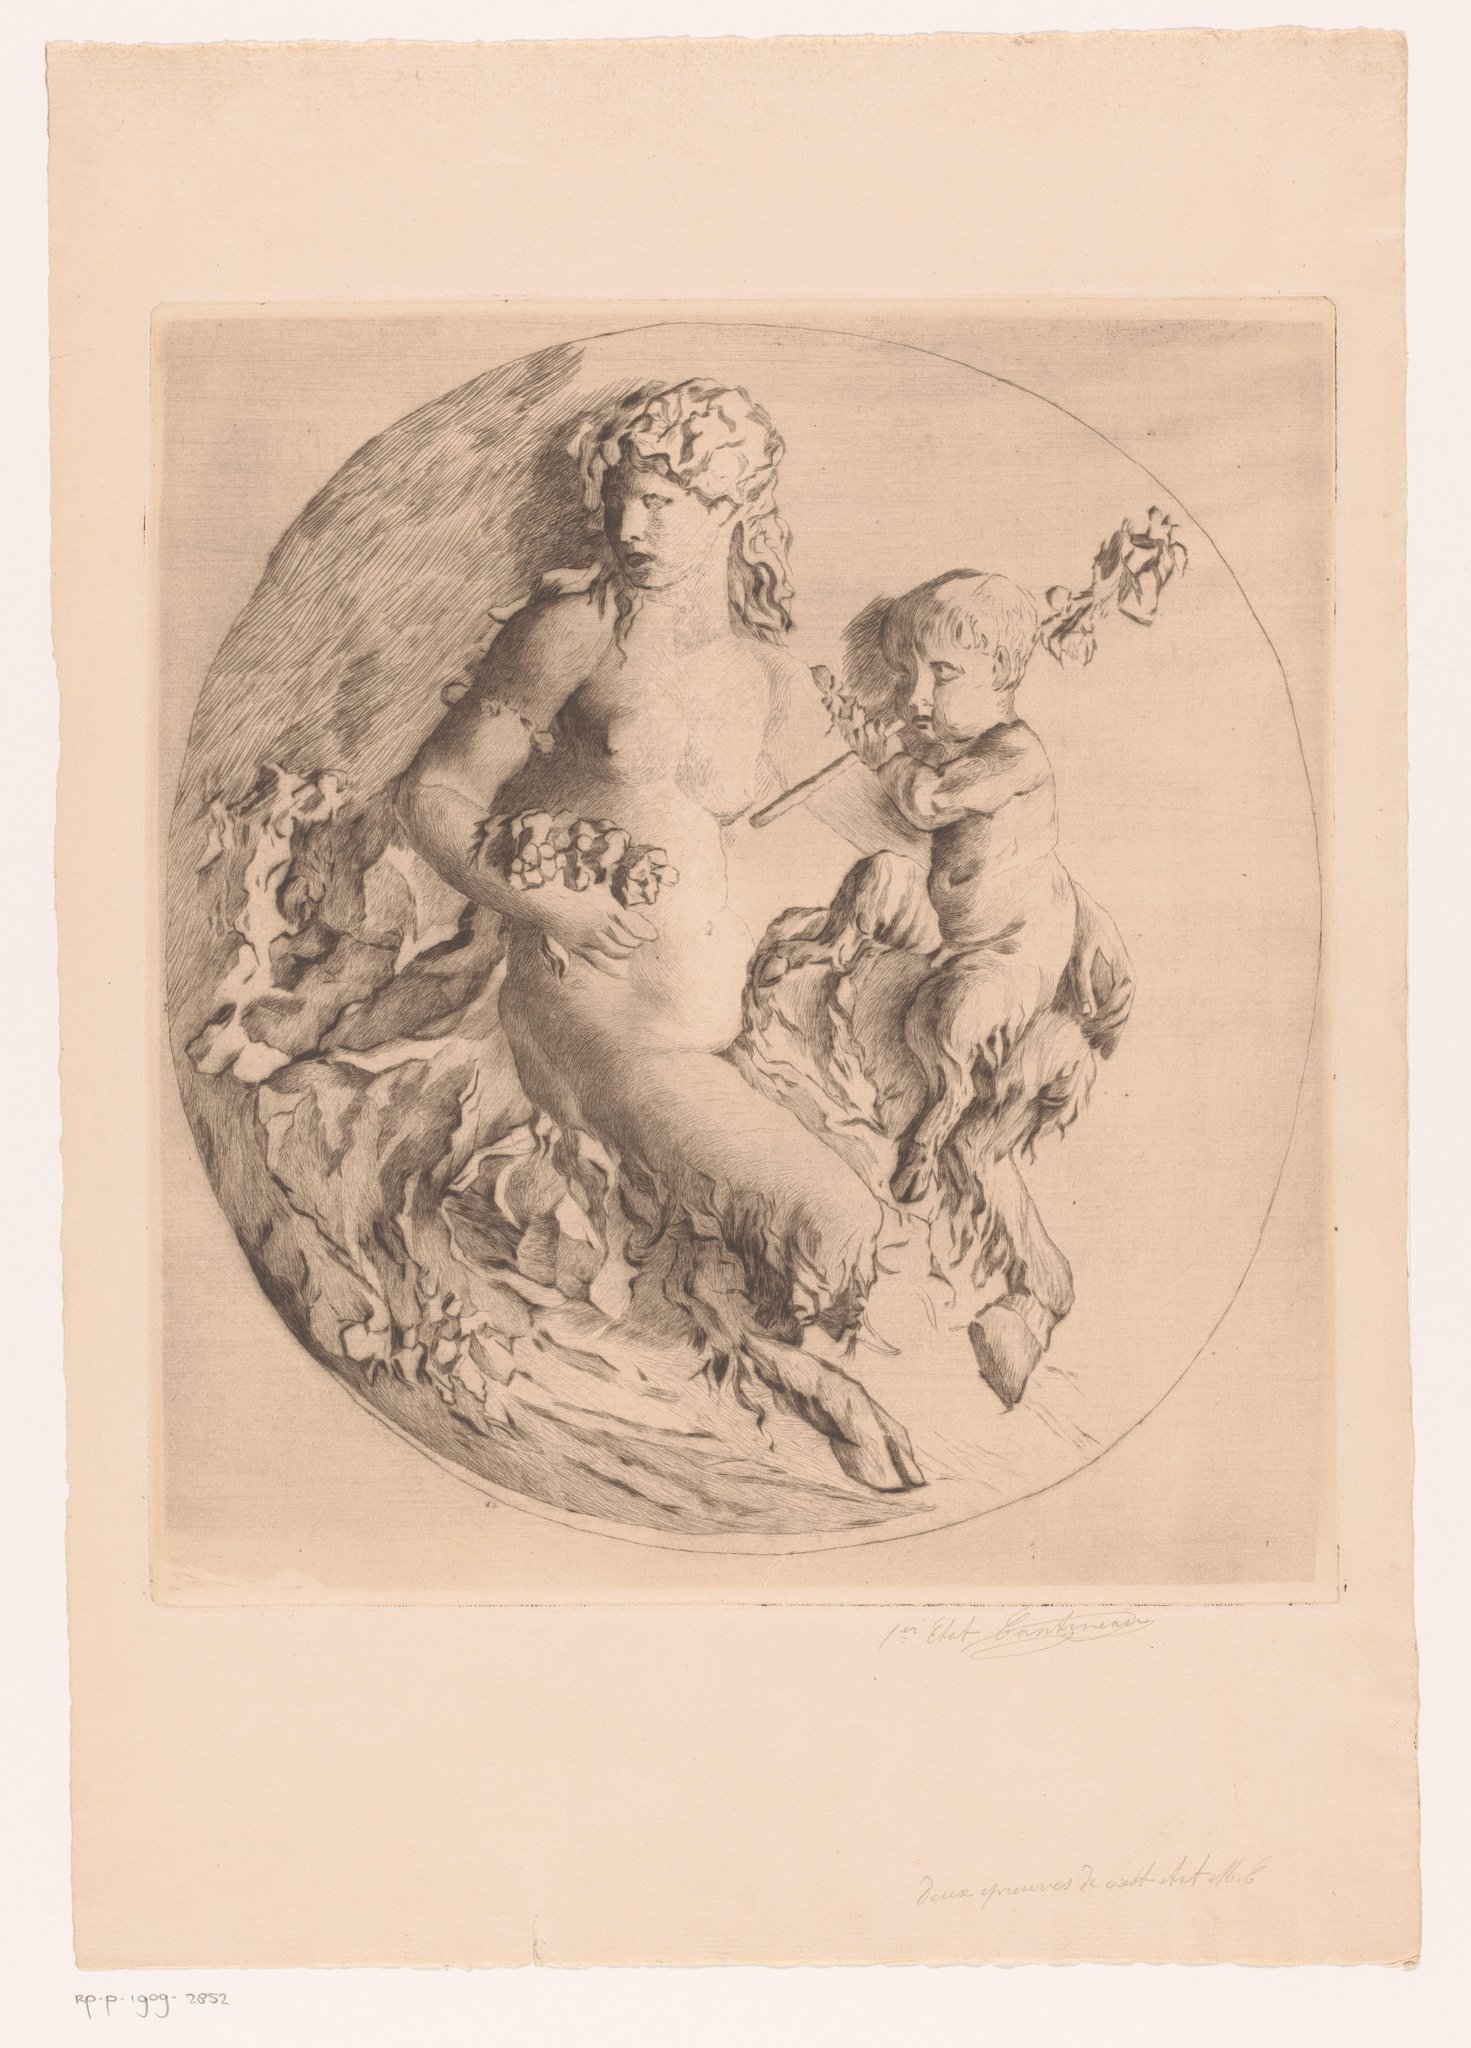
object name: print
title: Vrouwelijke satyr en satyrkind met spinrok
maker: mary hector rupert cantineau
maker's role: draughtsman, print maker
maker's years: 1875-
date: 1885-1909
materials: paper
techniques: drypoint, etching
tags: distaff, non-aggressive, friendly or neutral activities and relationships of satyr(s) - ll - female satyrs (in general)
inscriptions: annotation: ‘deux epreuves de c'est état M.C.’, annotation: ‘2 Bas reliefs d'après Caroeau par Cantineau’, collector's mark: Lugt 2228, annotation: ‘1er état’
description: Kopie naar een bas-reliëf. Sterfdatum prentmaker onbekend. Derhalve is voor bepaling van de rechten van dit object de verwervingsdatum aangehouden.